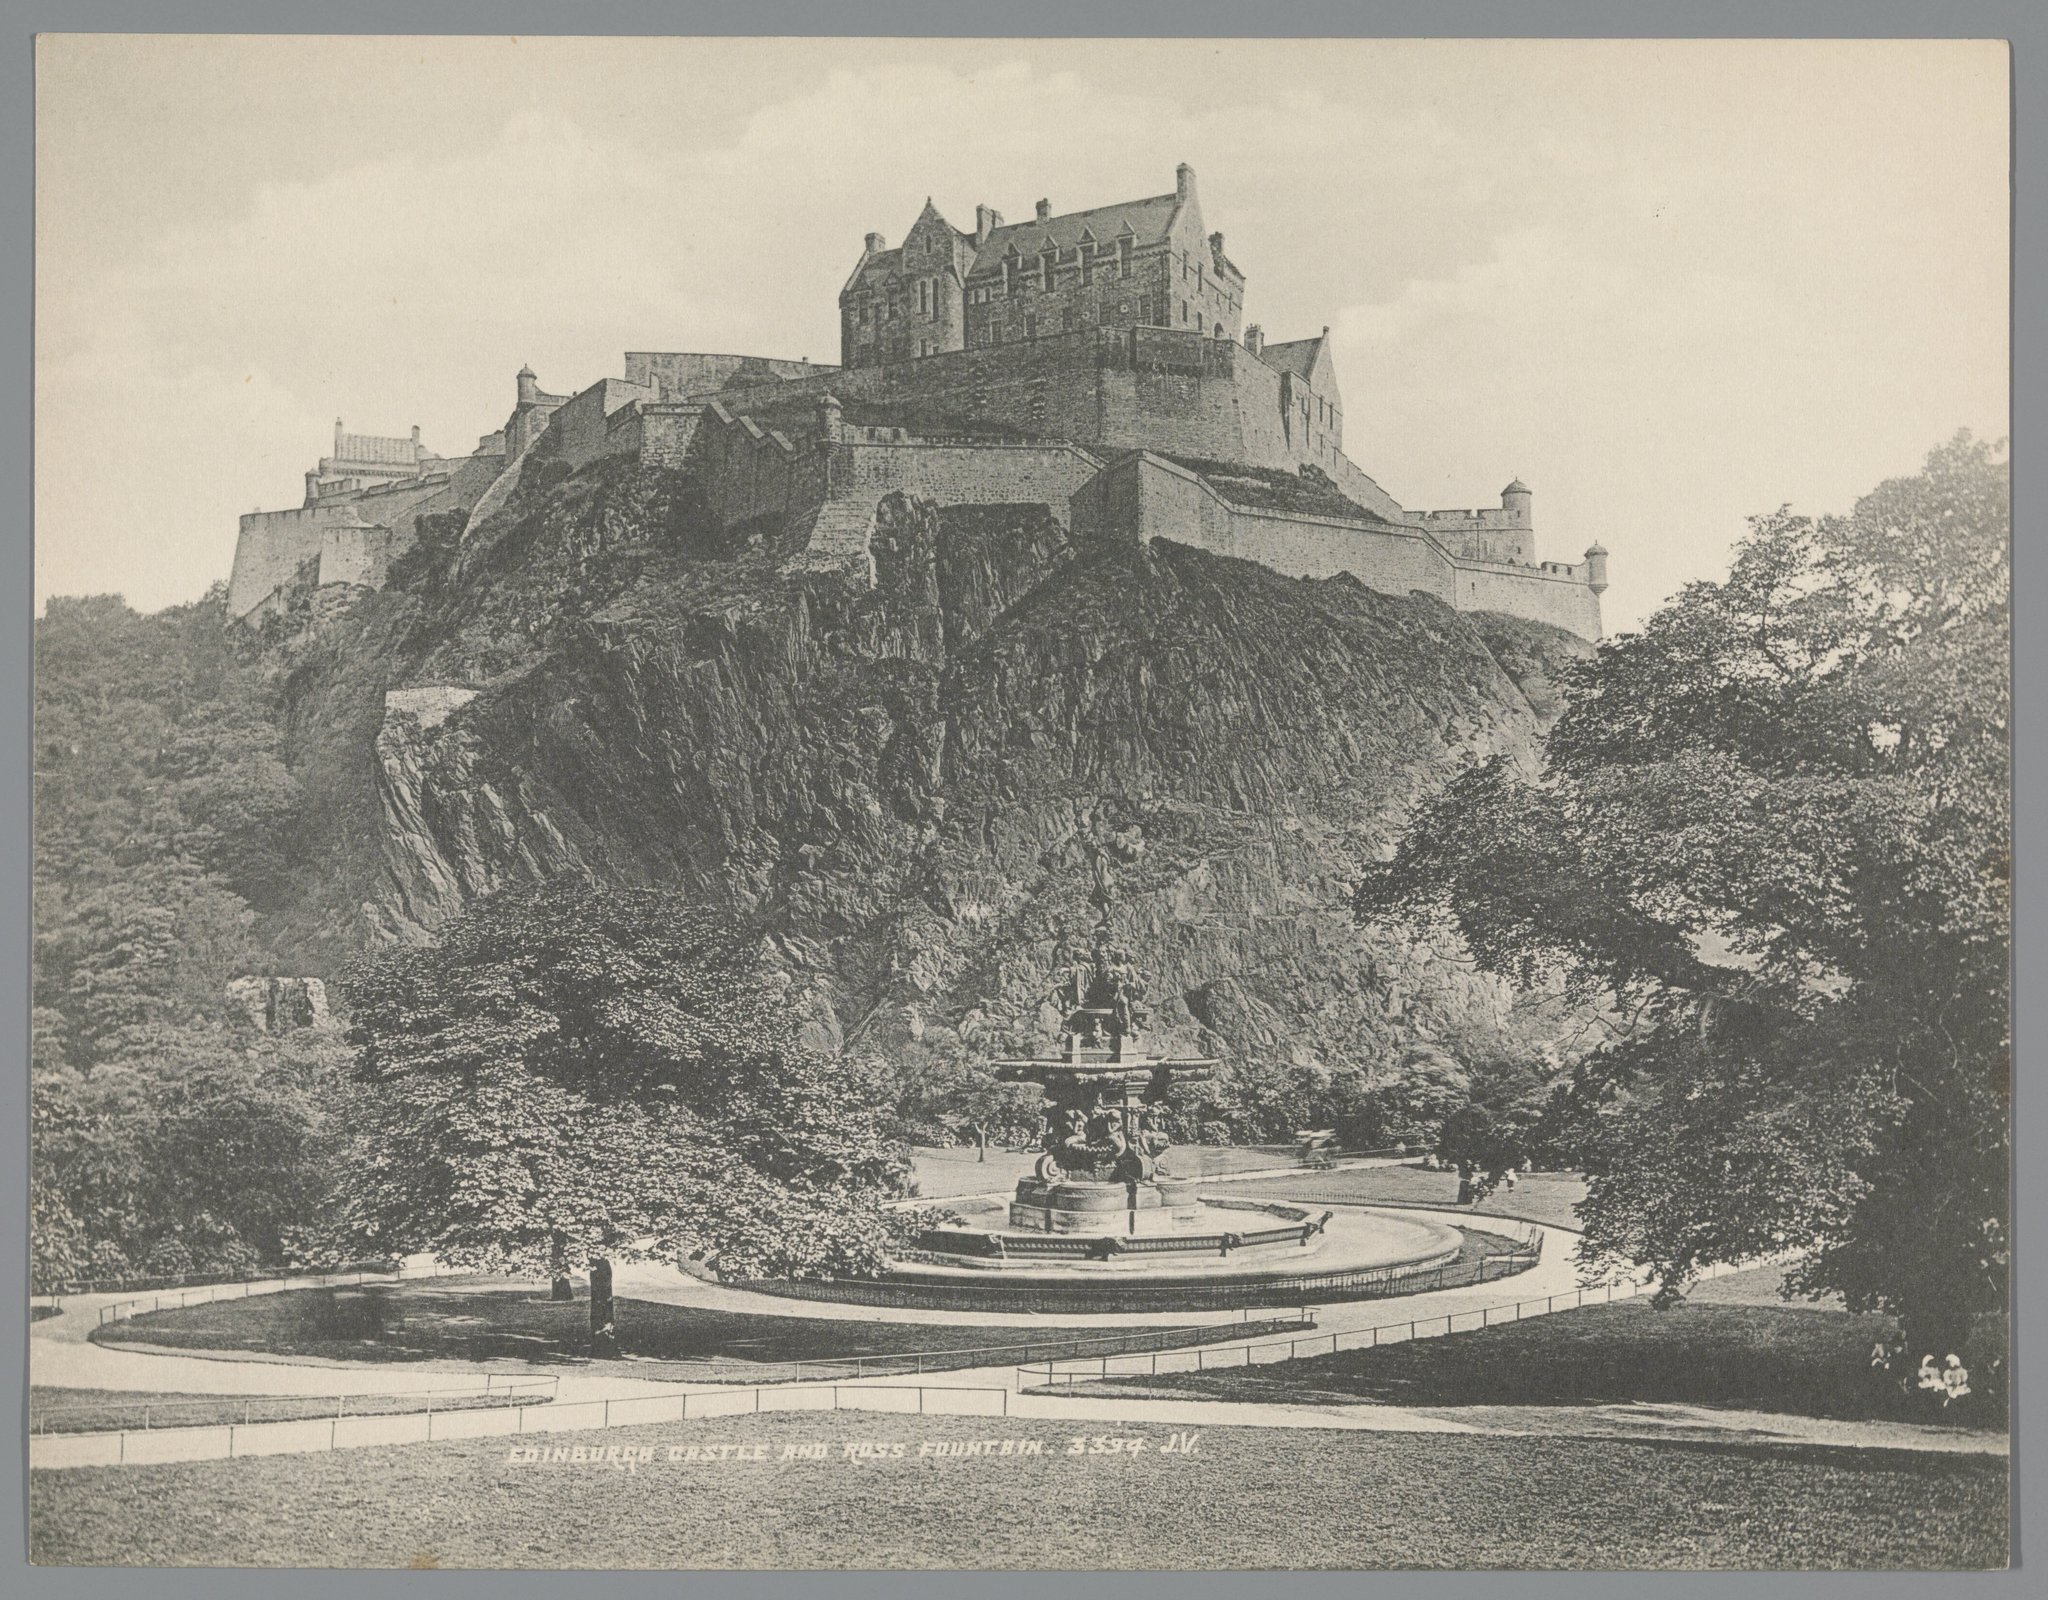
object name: print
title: Stadsgezicht van Edinburgh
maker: Anonymous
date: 1860-1915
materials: paper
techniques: photograph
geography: united kingdom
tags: edinburgh